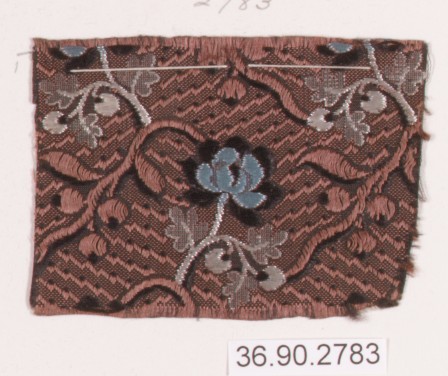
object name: piece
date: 1801-1900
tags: flowers,leaves